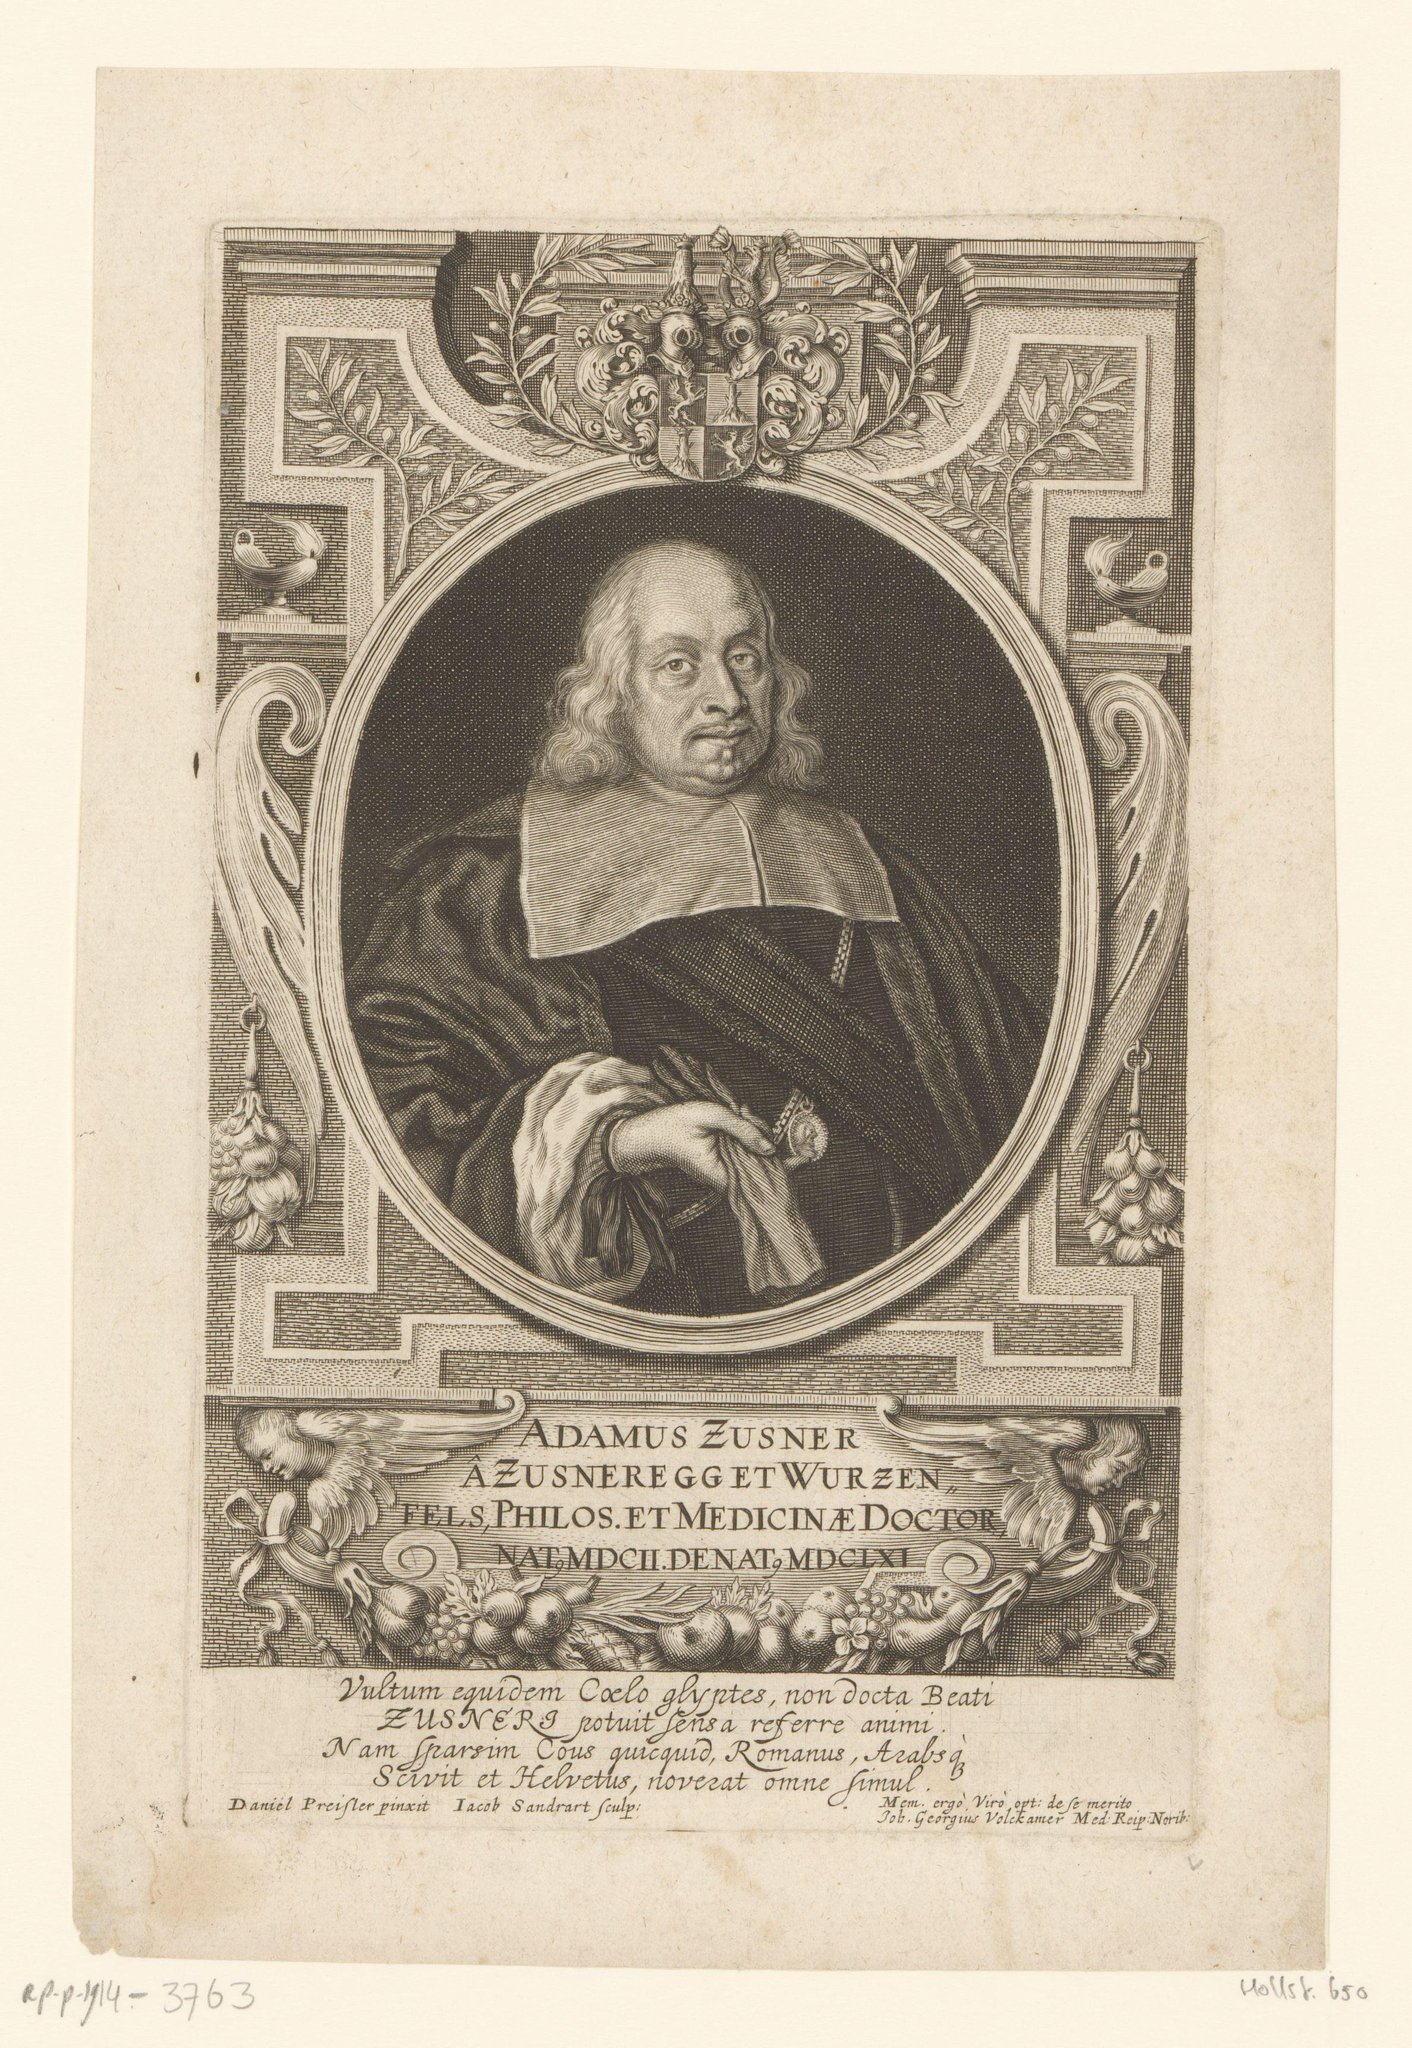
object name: print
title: Portret van Adam Zusner von Zusneregg und Würzenfels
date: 1662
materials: paper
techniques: engraving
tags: gloves, mittens, etc., historical persons, pendant, trinket, 'breloque', oil-lamp, armorial bearing, heraldry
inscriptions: collector's mark: Lugt 2228